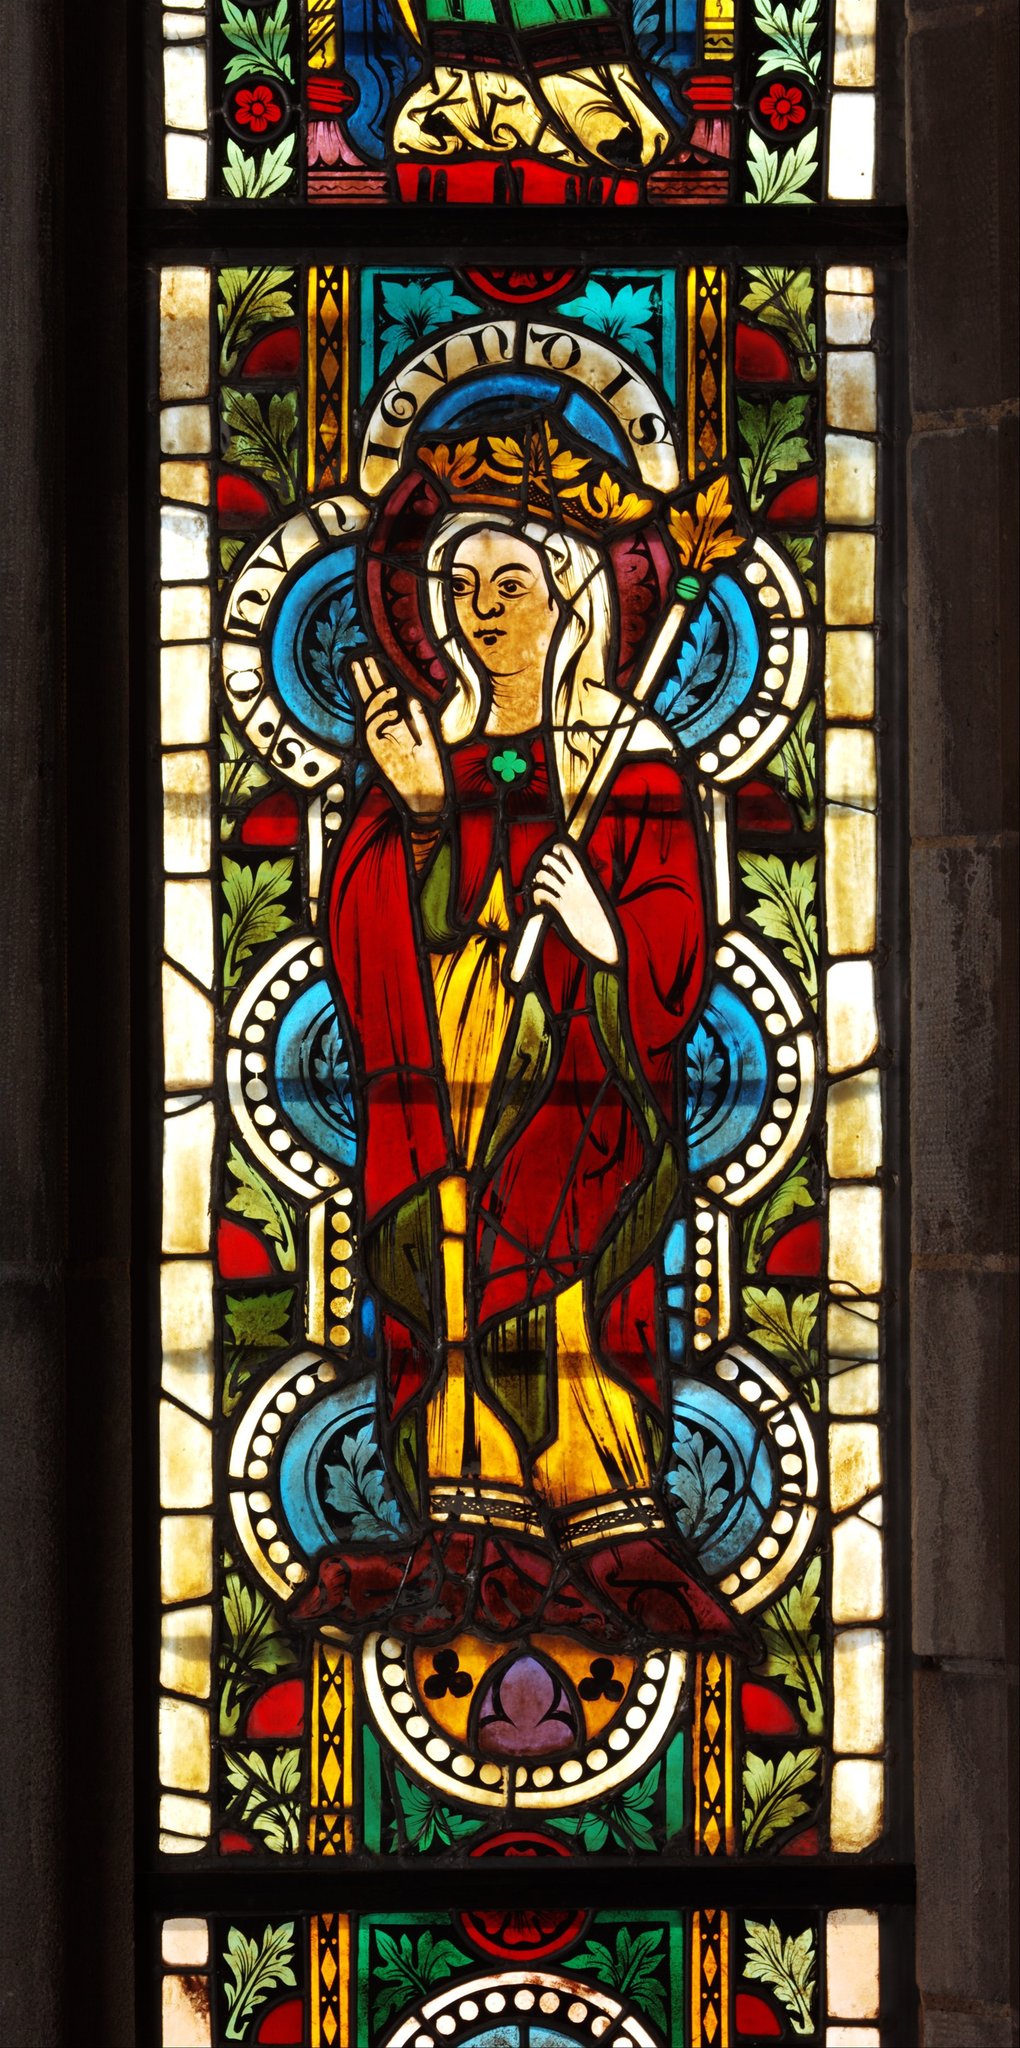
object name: panel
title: Stained Glass Panel with Queen Kunigunde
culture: austrian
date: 1340-1350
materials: glass, metal, paint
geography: austria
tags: queens